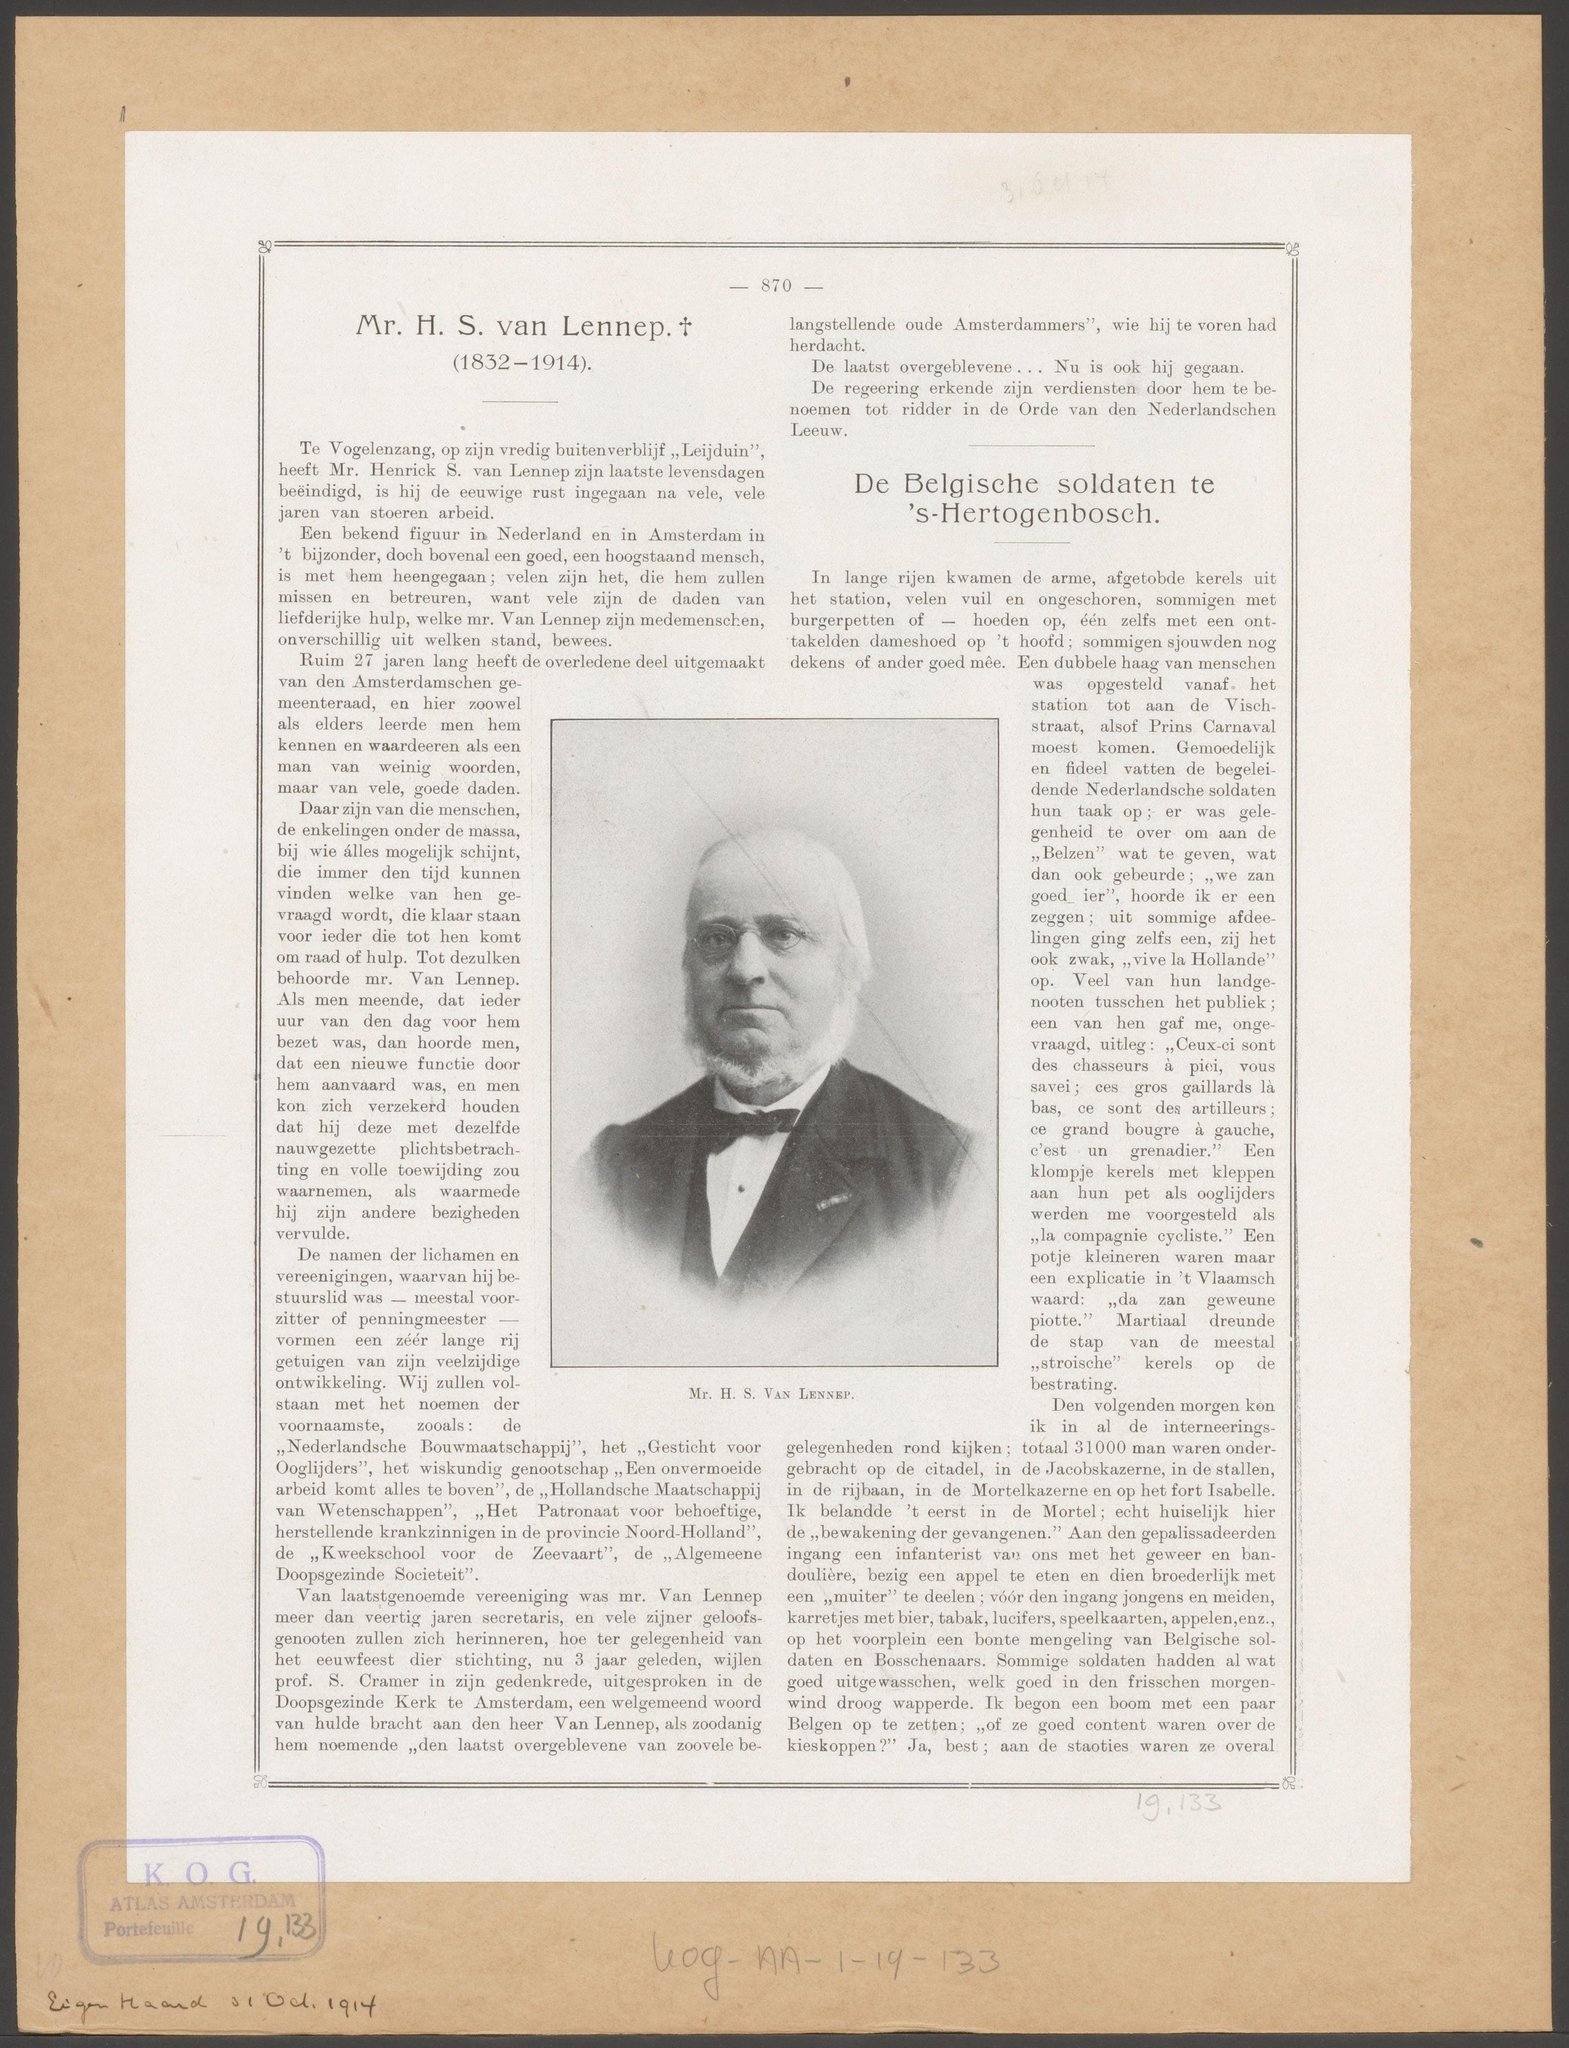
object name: page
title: Aankondiging van het overlijden van Henrick Samuel van Lennep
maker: Anonymous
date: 1914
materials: paper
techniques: letterpress printing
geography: haarlem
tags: historical persons, politician, e.g. party leader, amsterdam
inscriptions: collector's mark: ‘19,133’ Lugt 1641b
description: Onderwerpsrubriek binnen de Atlas Amsterdam: Herinneringen aan regeringsleden en hunne huisgezinnen [na 1800].